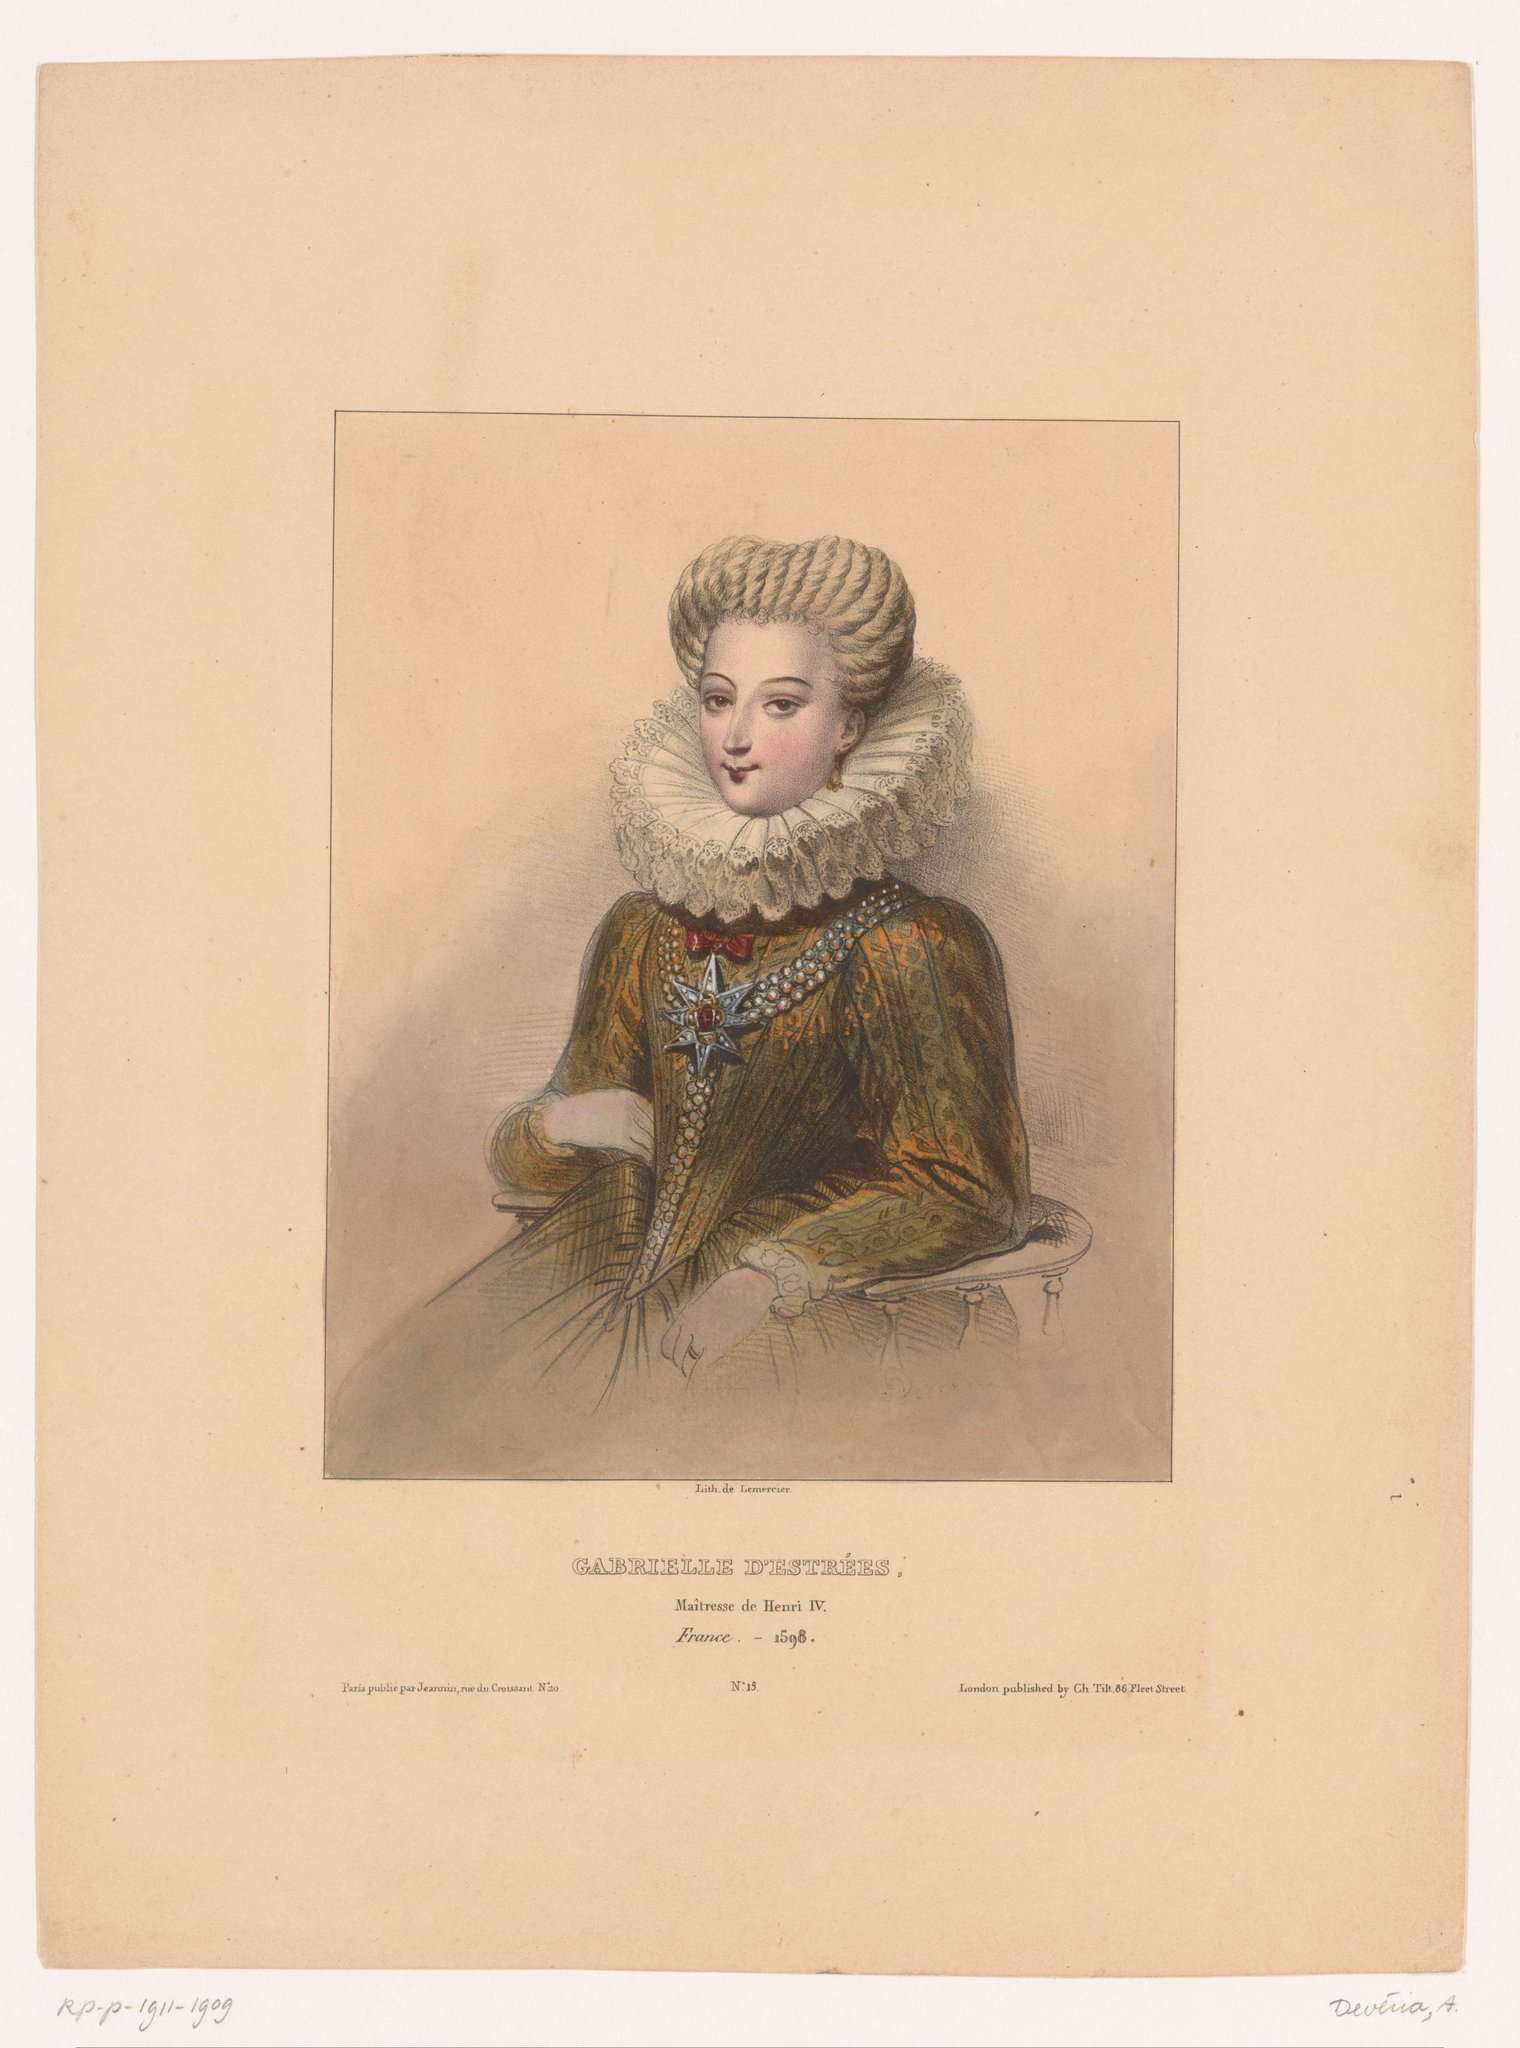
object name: print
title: Gabrielle d'Estrées, maîtresse de Henri IV, 1598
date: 1832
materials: paper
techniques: hand coloring, lithograph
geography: paris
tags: historical persons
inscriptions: collector's mark: Lugt 2228a, check stamp: Lugt 3987